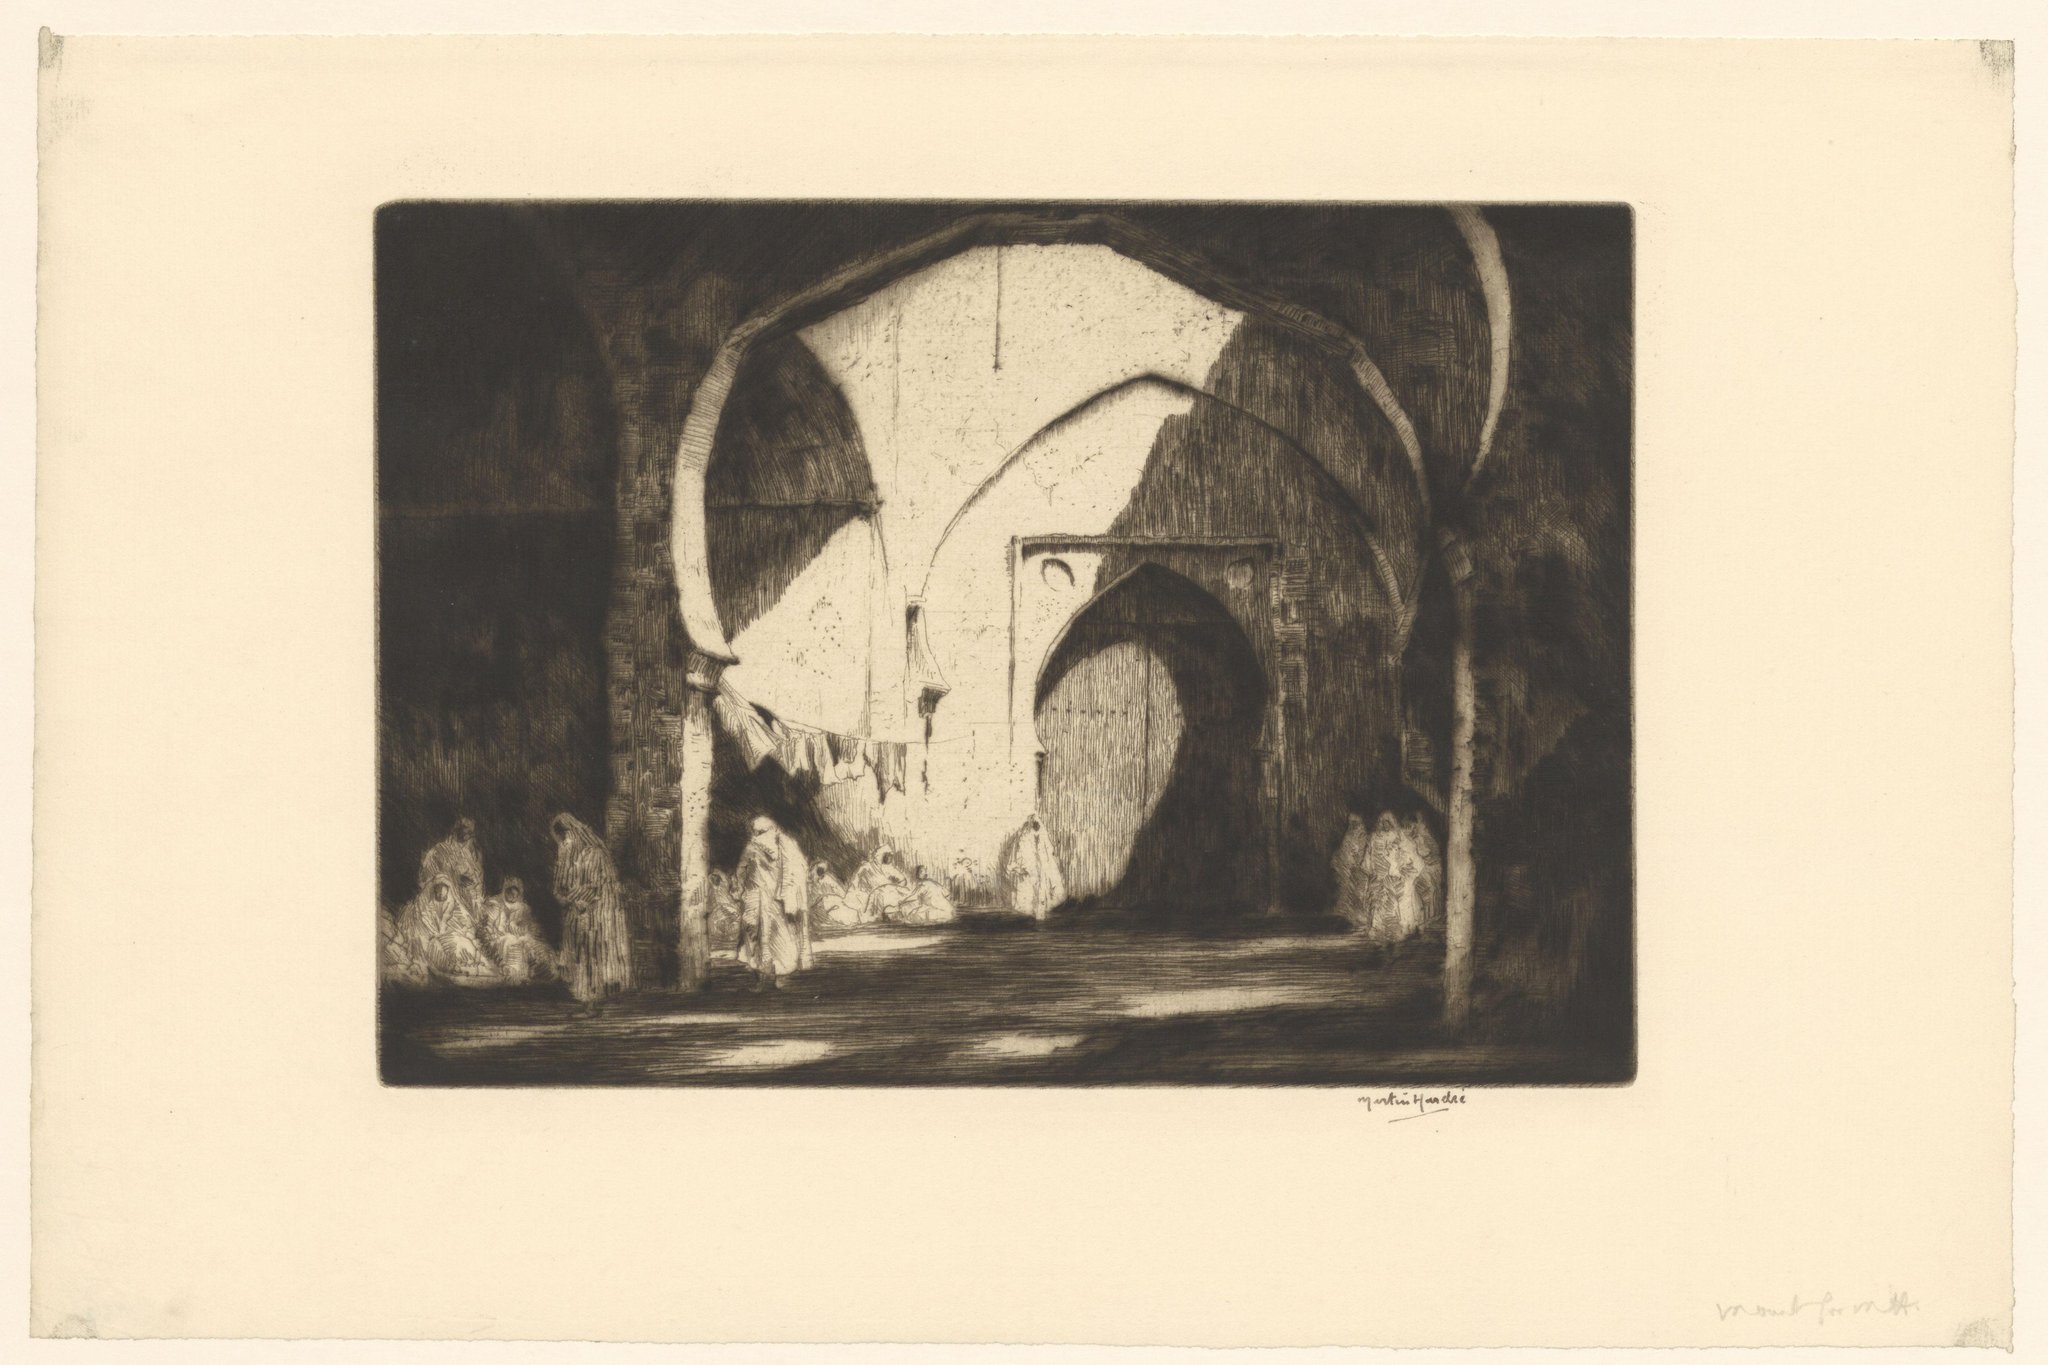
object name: print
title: Overdekte markt in Fez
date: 1928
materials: paper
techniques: drypoint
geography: fez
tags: market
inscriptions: collector's mark: Lugt 2760, collector's mark: Lugt 2228, annotation: ‘Martin Hardie’